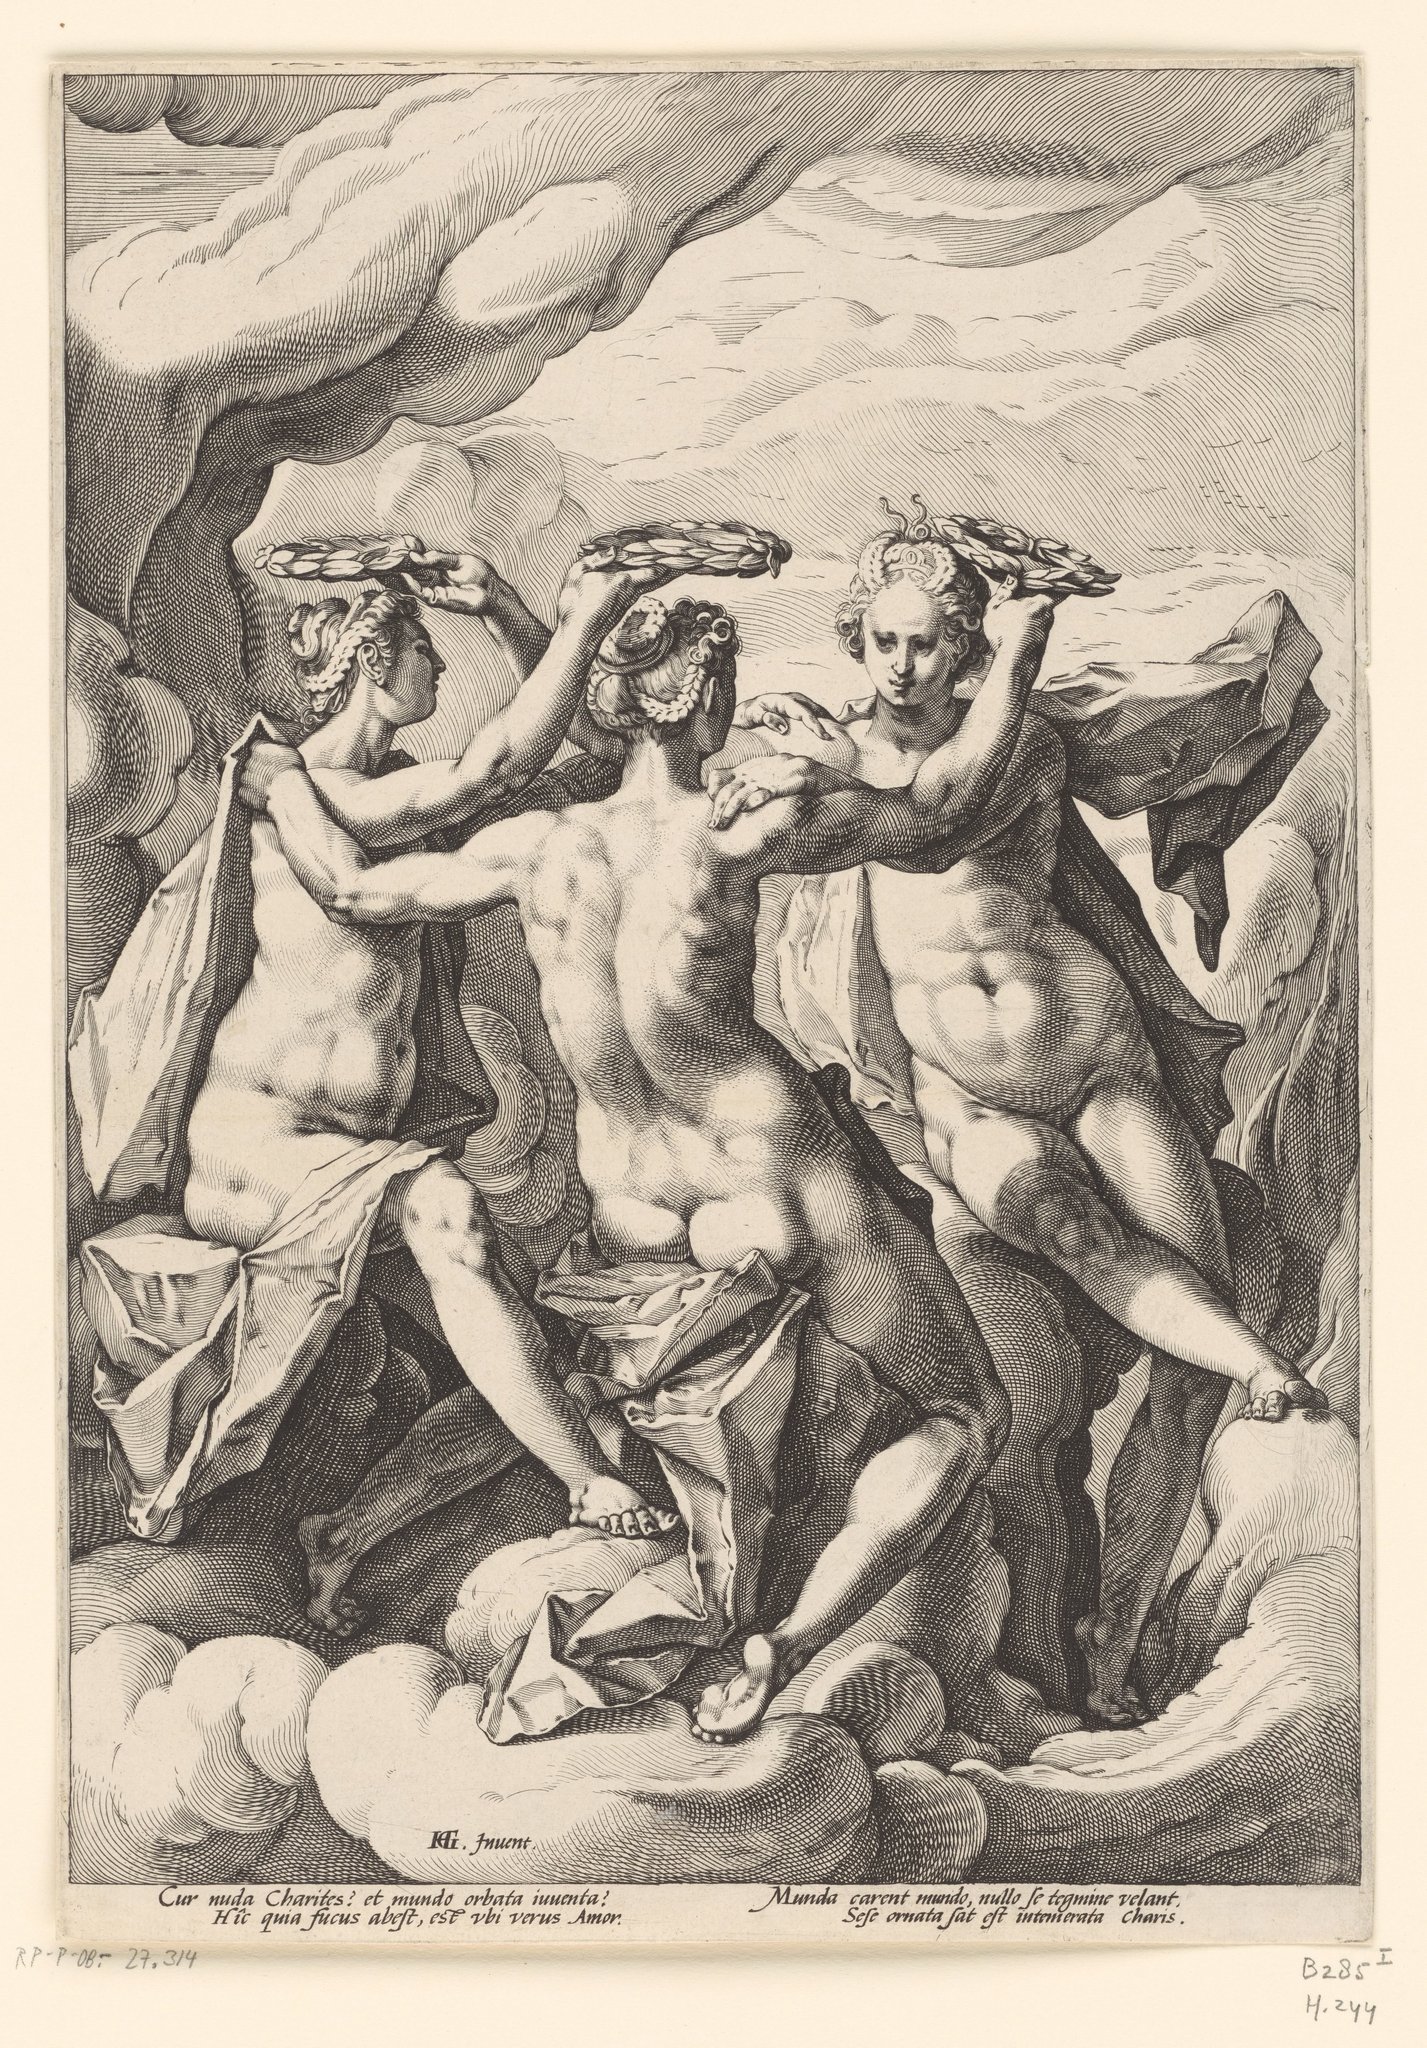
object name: print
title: Mythologische en allegorische voorstellingen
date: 1588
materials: paper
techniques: engraving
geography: haarlem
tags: graces (charites), generally three in number; 'gratie' (ripa)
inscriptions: collector's mark: Lugt 240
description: De drie gratiën tussen de wolken. De drie vrouwenfiguren houden ieder een lauwerkrans boven elkaars hoofd.